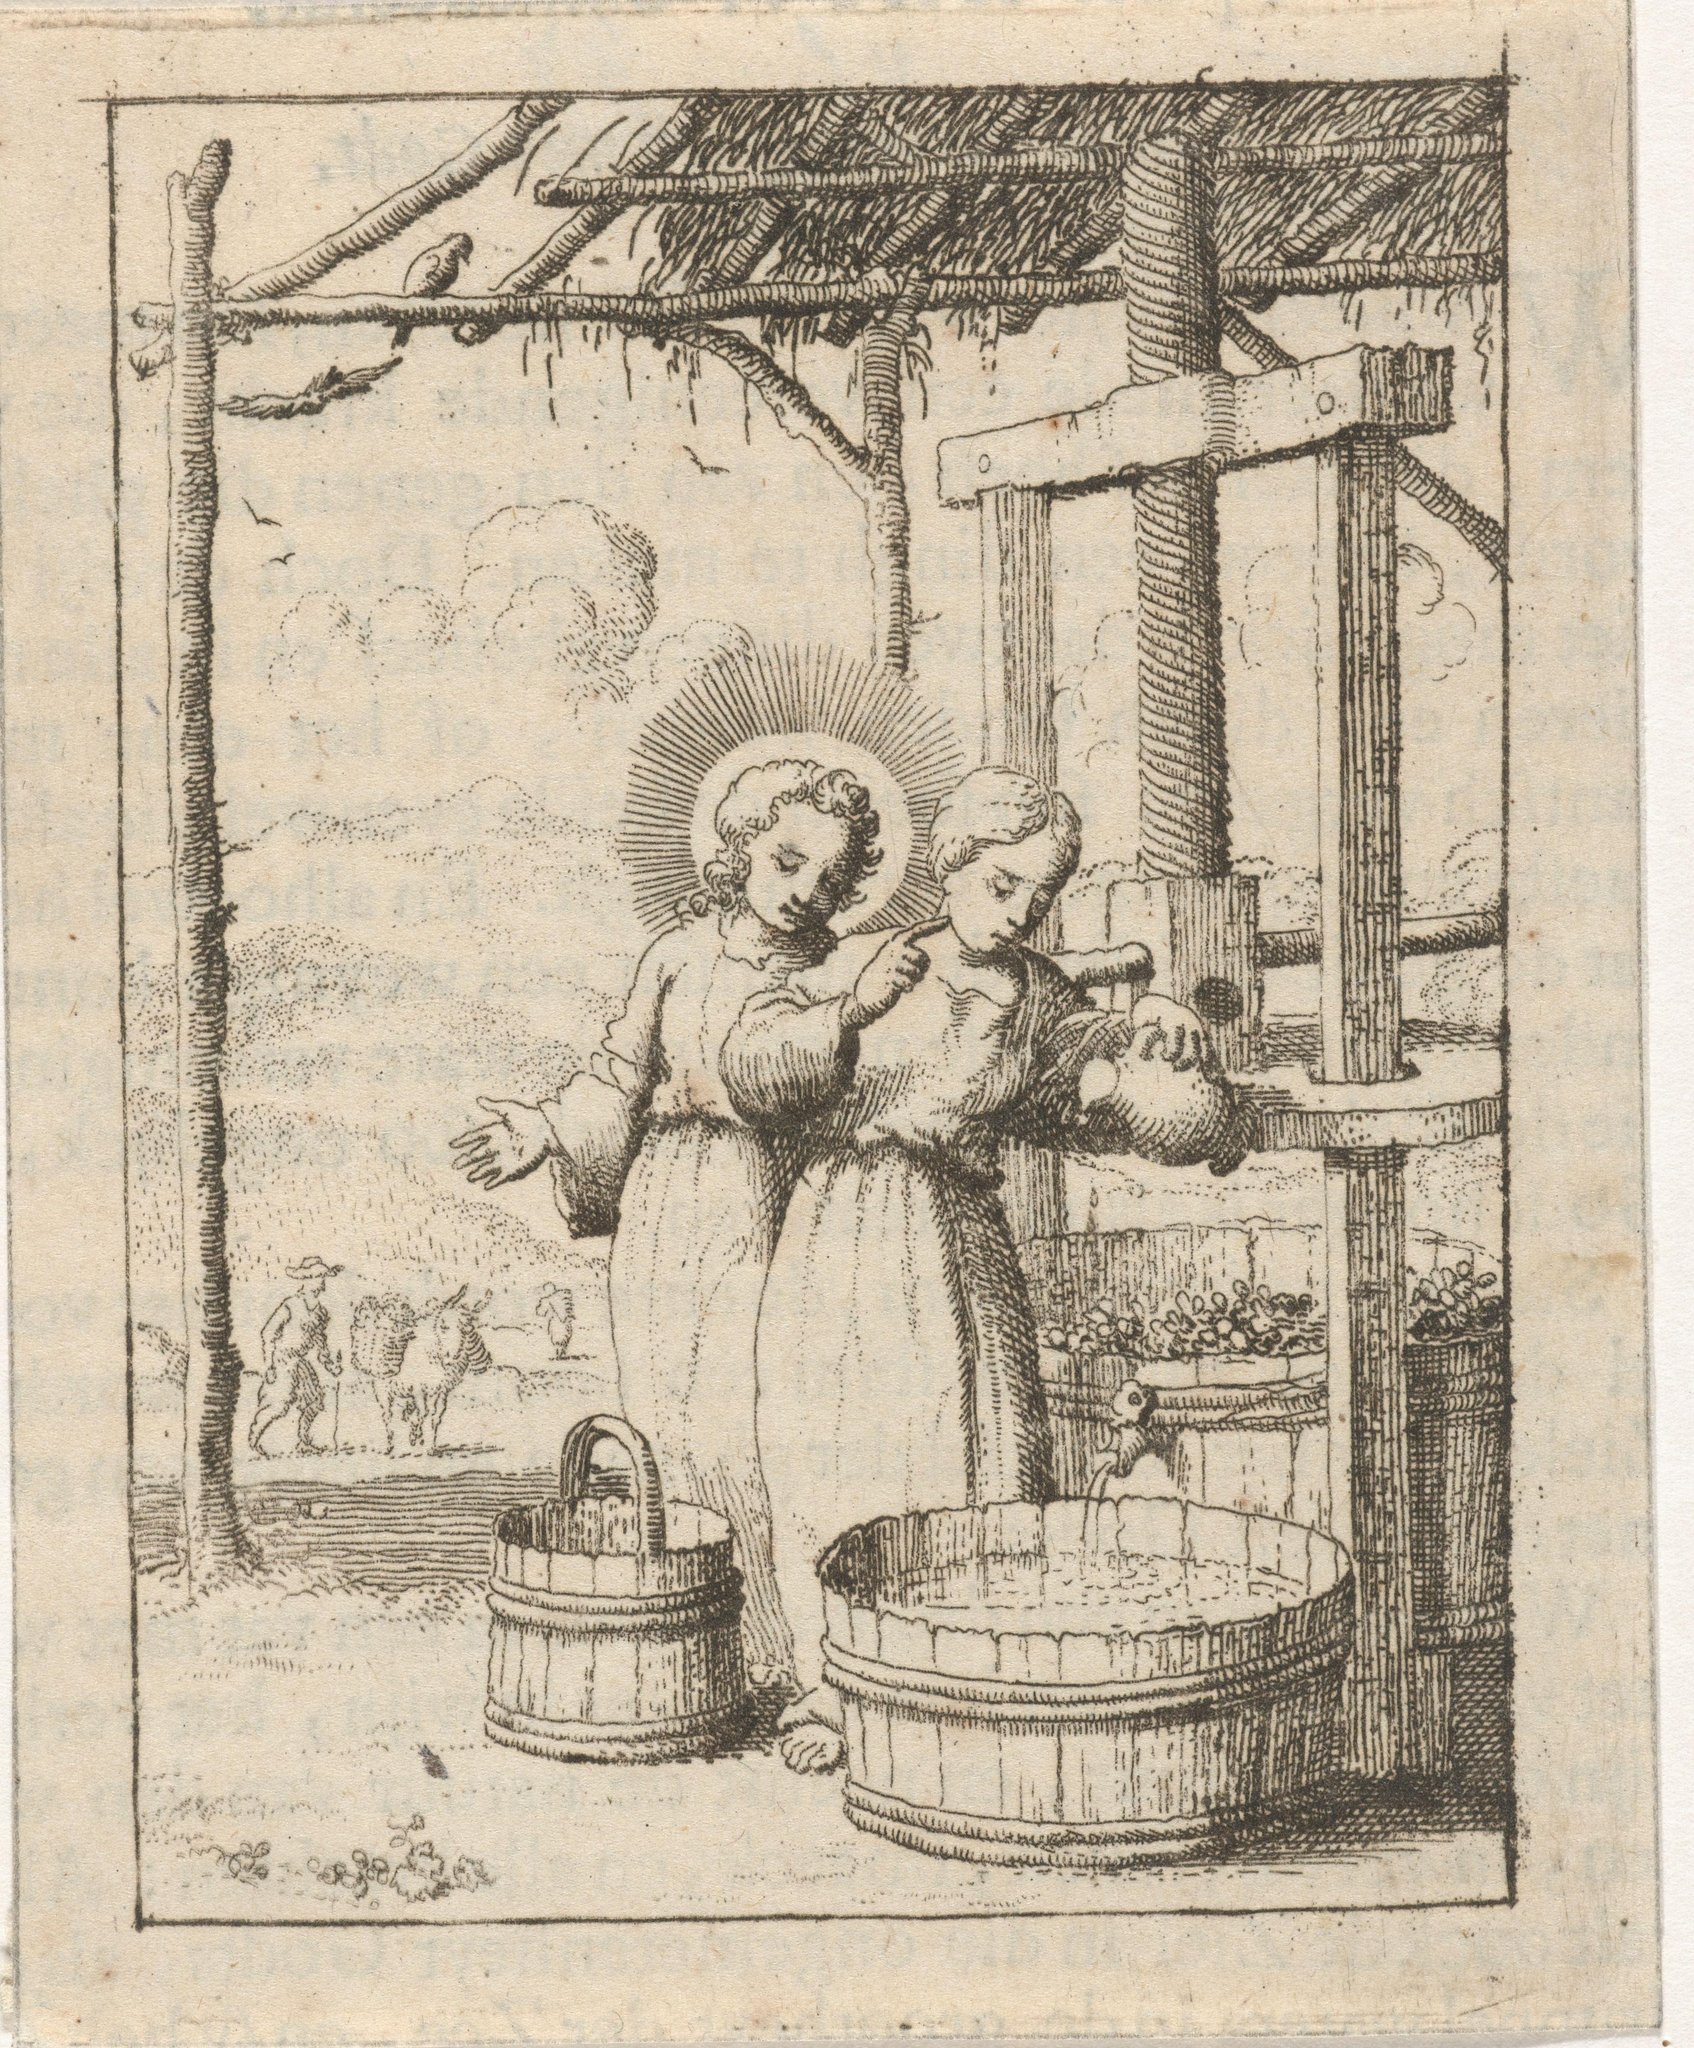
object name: book illustration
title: Christus en de gepersonifieerde ziel vullen bij een wijnpers een kruik met wijn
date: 1678-1687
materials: paper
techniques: etching, letterpress printing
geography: amsterdam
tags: wine-press, christ and the soul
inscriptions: collector's mark: Lugt 2228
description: Illustratie uit: Luyken, Jan. Jezus en de Ziel, 3 delen. Amsterdam: Pieter Arentsz II, 1678-1687. Tussen 1678-1744 verschenen van dit emblemataboek 10 edities.